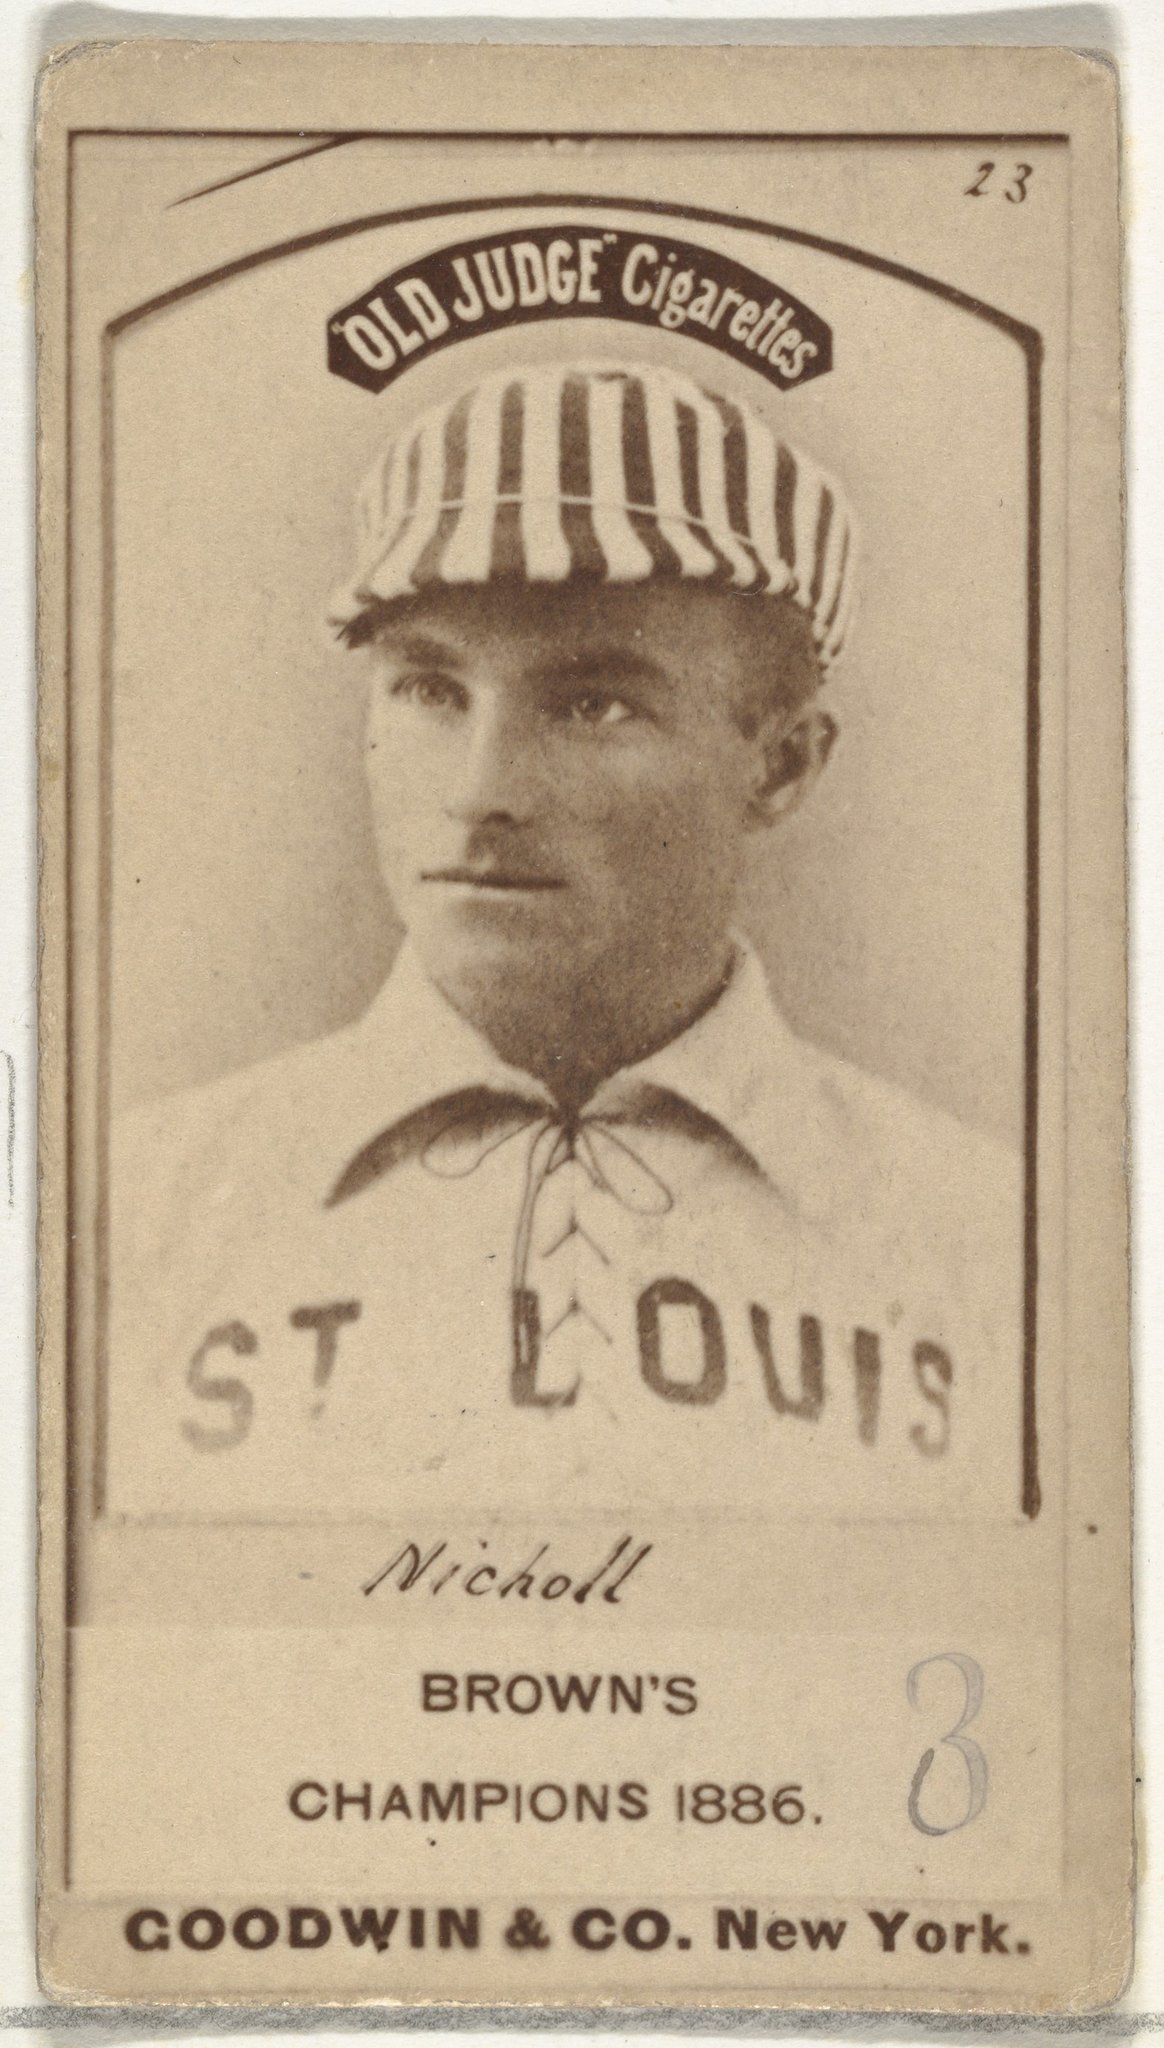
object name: baseball card, photograph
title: Hugh Nicol, St. Louis Browns, from the Old Judge series (N172) for Old Judge Cigarettes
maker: goodwin & company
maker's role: publisher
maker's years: 1850-1950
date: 1886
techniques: albumen silver print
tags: men,portraits,baseball,athletes